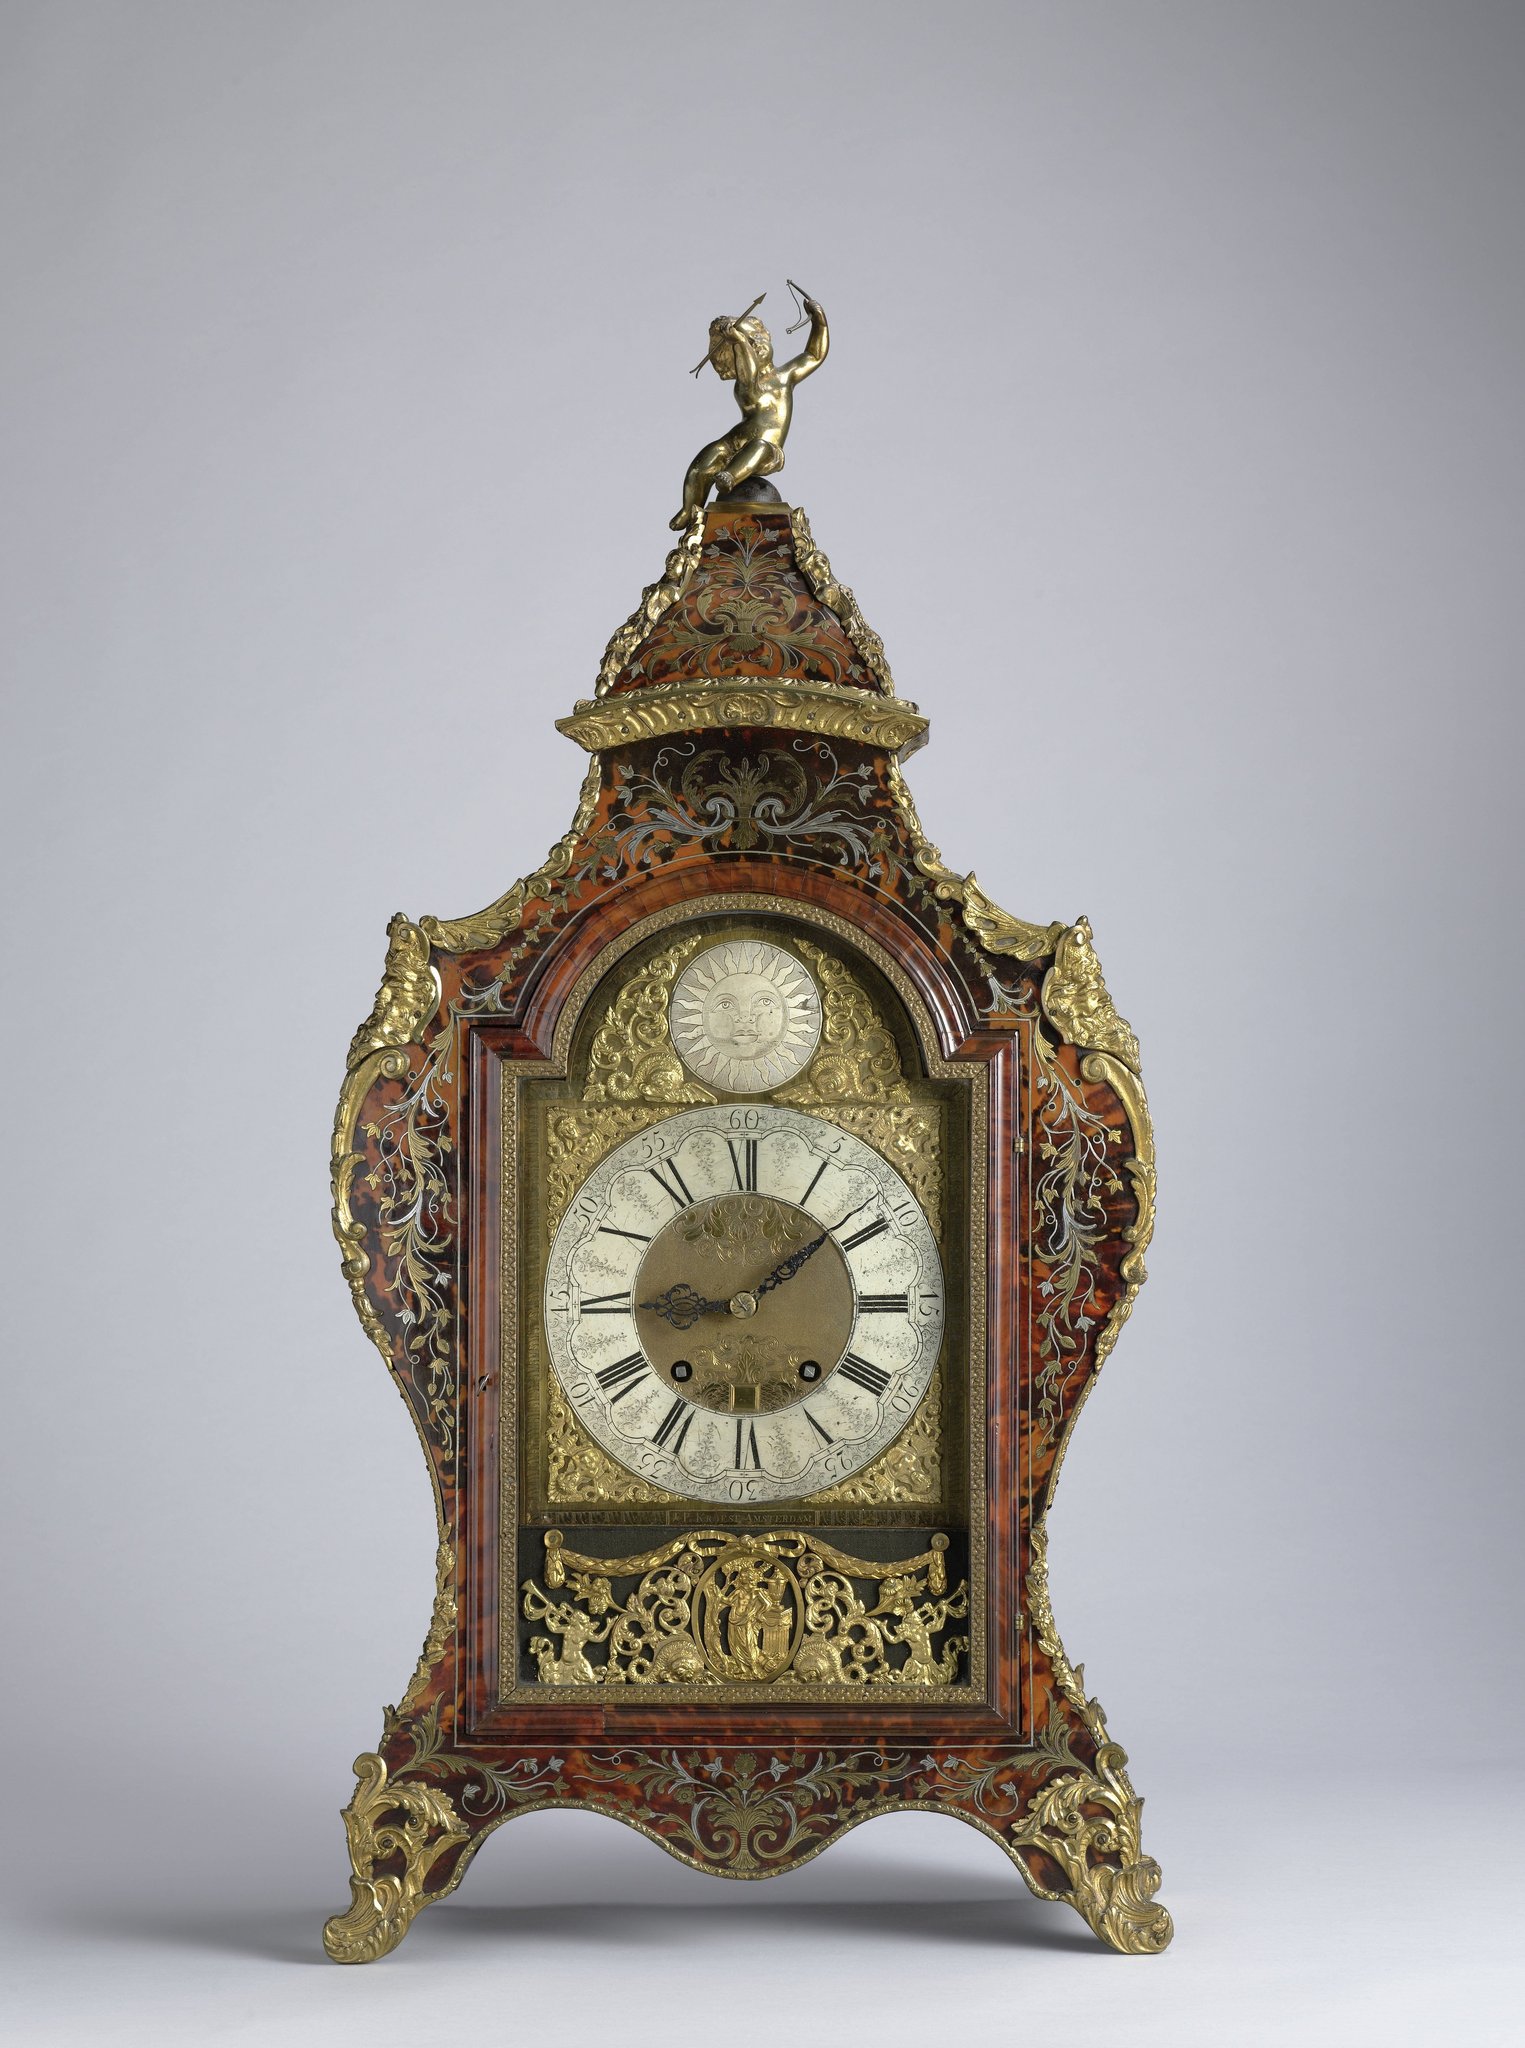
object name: table clock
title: Tafelklok of consoleklok, gefineerd met marqueterie van koper en tin op een fond van schildpad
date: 1780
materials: copper, wood, tin, shell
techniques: marquetry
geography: england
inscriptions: signature: ‘IP KROESE AMSTERDAM’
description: Tafelklok of consoleklok van eikenhout, gefineerd met marqueterie van koper en tin op een fond van schildpad op rode foelie, en met verguld bronzen beslag. De kast heeft een gewelfde onderkant en gebogen zijden. Hij verjongt zich naar boven toe en wordt bekroond door een afneembare kap. De kast heeft in de voorzijde een rechte vensterdeur met een geknakt boogvormige bovenrand, omgeven door een profielrand van schildpad, waarbinnen een gegoten koperen rand met balusters en slingers. De gegraveerde wijzerplaat van wit gekleurd metaal wordt omgeven door vier gegoten hoekstukken met vrouwenfiguren. In de lunet wordt een ronde plaat van wit gekleurd metaal, gegraveerd met de zon, geflankeerd door gegoten zwikstukken met dolfijnen. De wijzerplaat is bevestigd op een koperen plaat met een gegraveerde rand met midden onder de signatuur IP KROESE AMSTERDAM. Onder de wijzerplaat bevindt zich een houten, met zwarte stof beklede plaat, waarop in het midden een ovaal, verguld koperen, gestrikt medaillon met Apollo (?) met boog en pijlenkoker, afhangend van laurierslingers. Het wordt geflankeerd door ornamenten met dezelfde dolfijnen die ook in de lunet voorkomen, bloemtakken, en trompetblazende zeemeerminnen. De kast en de kap zijn aan de voor- en zijkanten ingelegd met blad- en bloemranken. De kast rust op vier koperen poten met rocailles en bladeren en vertoont op de vier bovenste hoeken gebaarde maskers. Langs de randen rijk versierd beslag. De kap wordt bekroond door een verguld bronzen jongetje. De klok heeft een slingeruurwerk, uurslagwerk en repetitie.